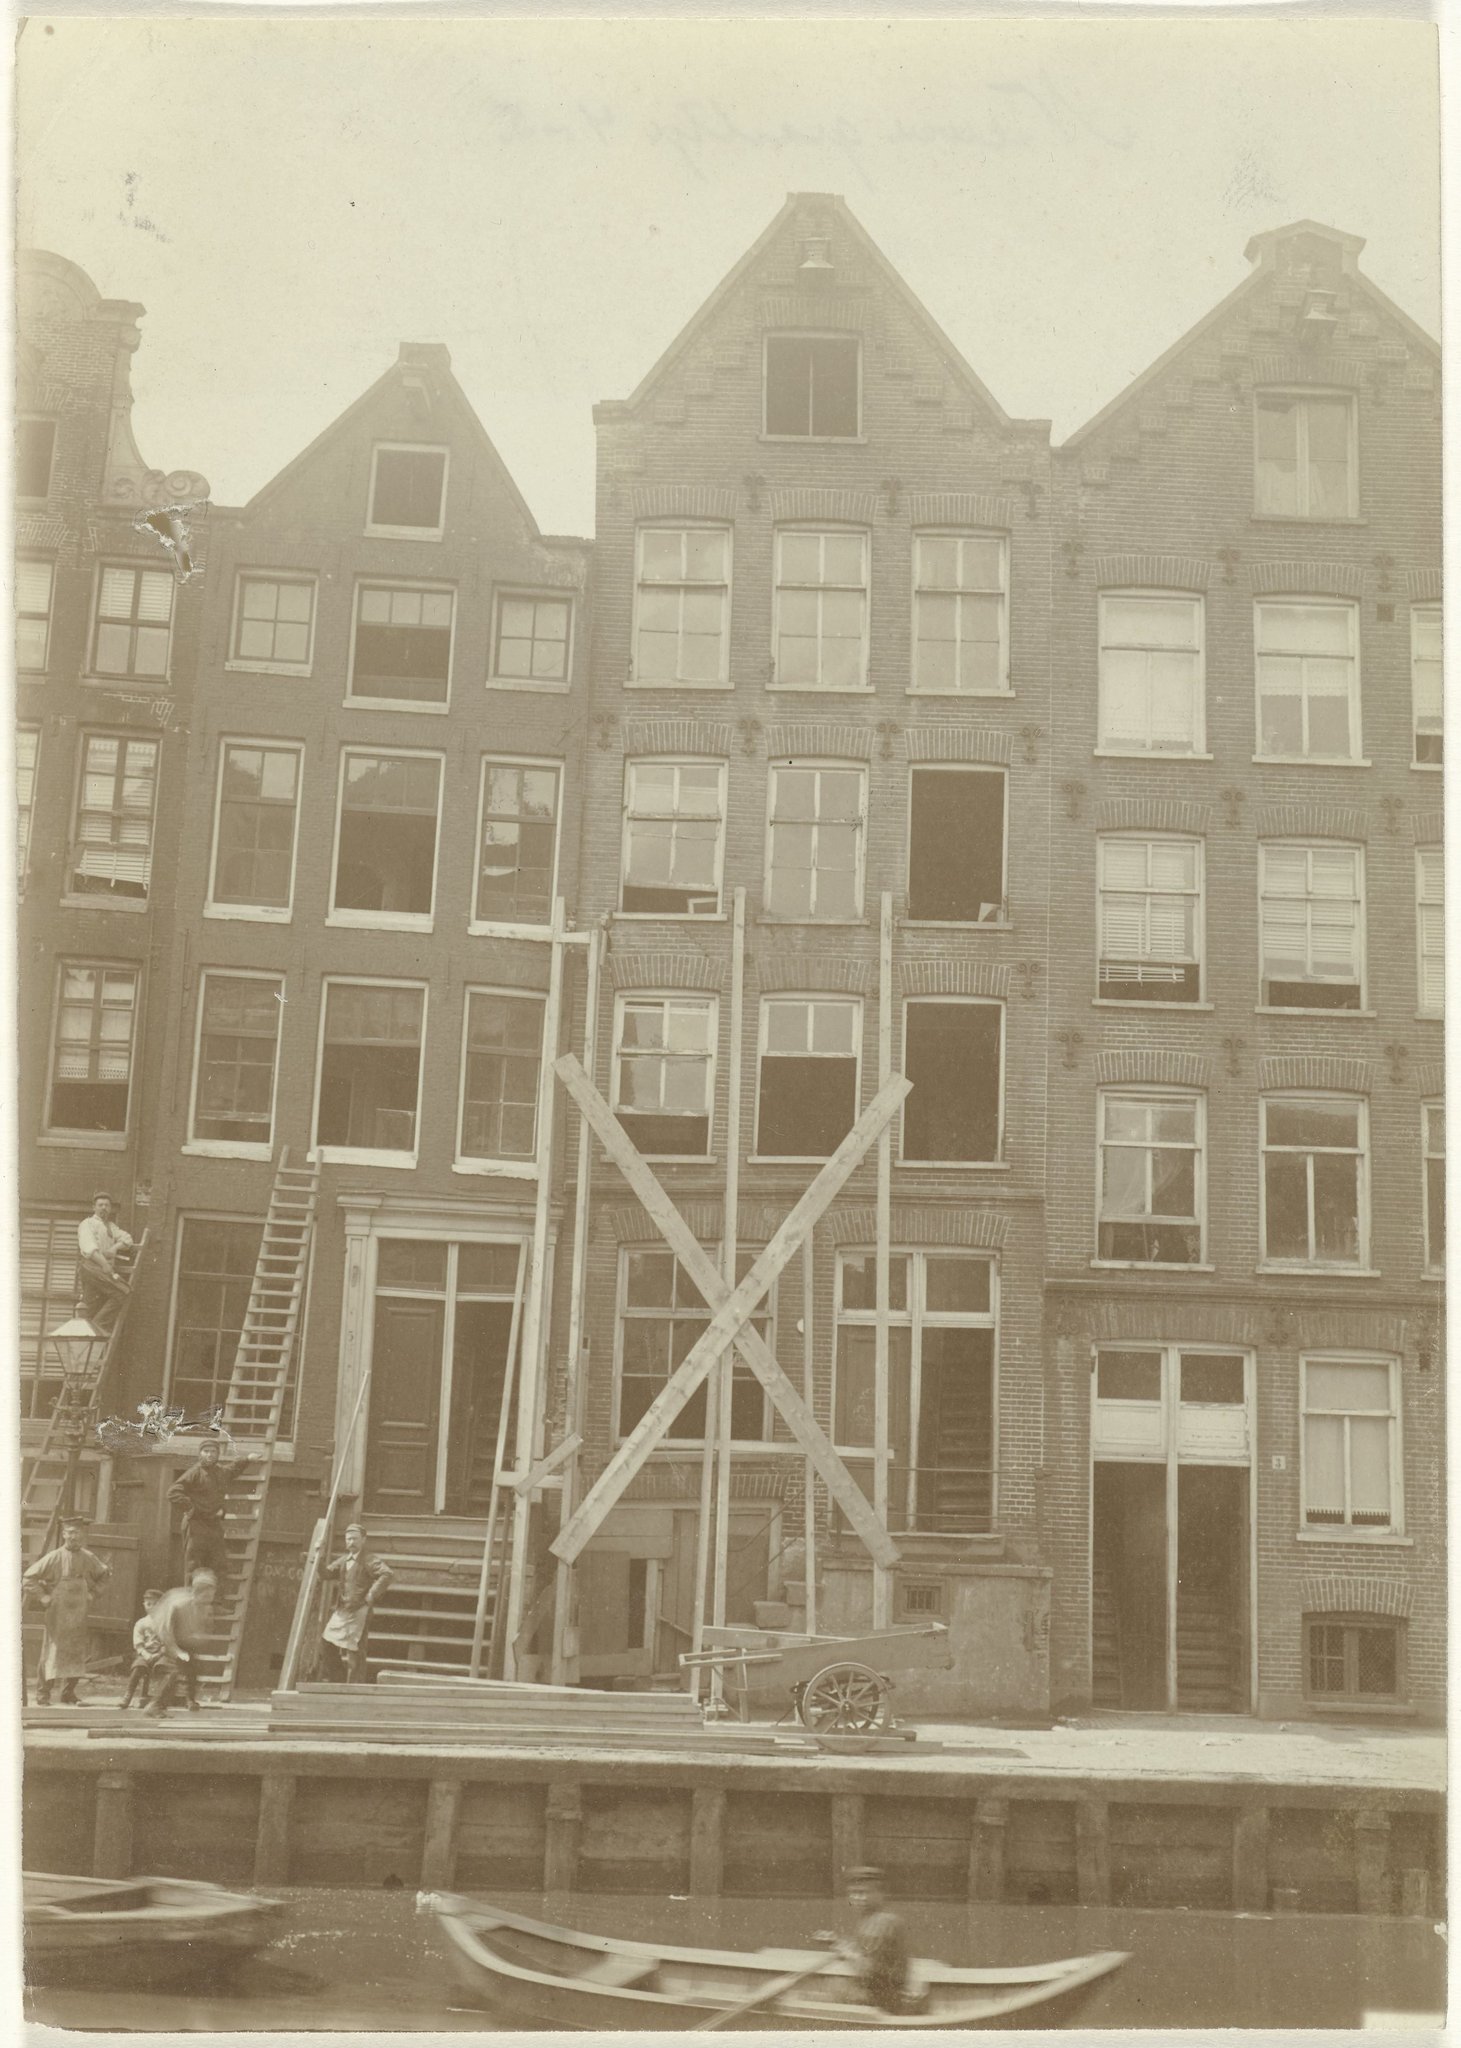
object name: photograph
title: Gevels aan het Nieuwegrachtje in Amsterdam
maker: Anonymous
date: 1880-1910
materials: paper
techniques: matte daylight collodion silver print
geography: amsterdam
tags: urban housing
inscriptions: inscription: ‘geveltjes aan zuid Valkenburgerstraat/ verdewenen bij IJ. tunnelbouw’